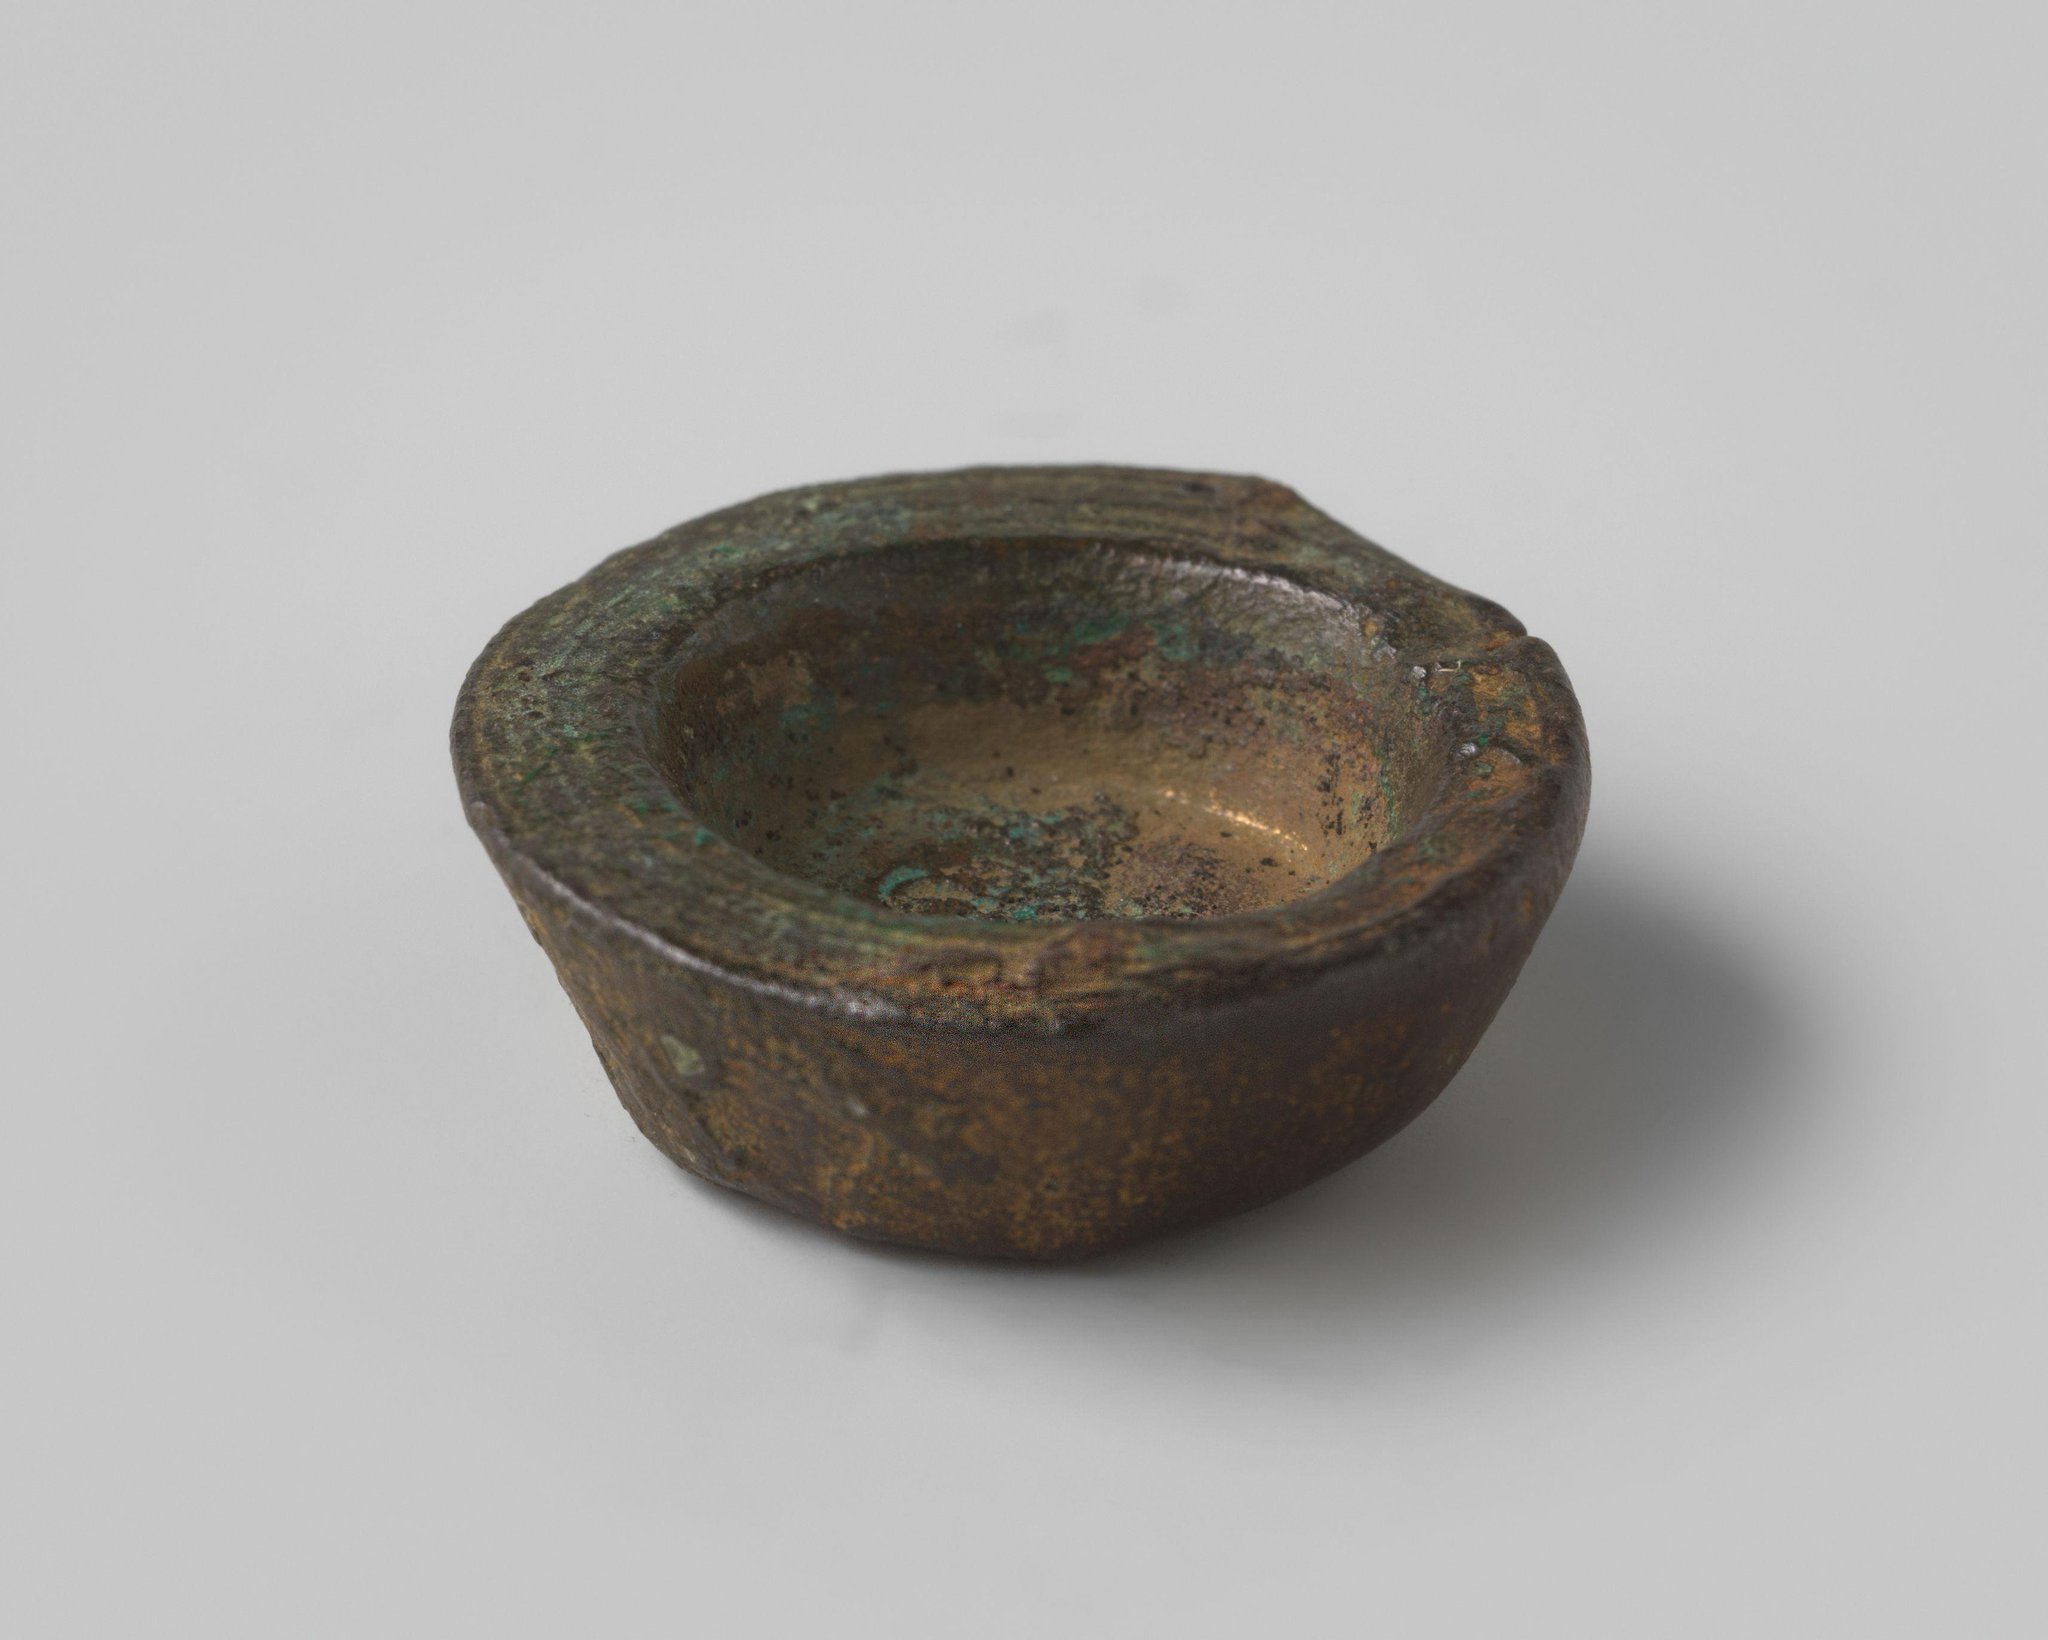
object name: sluitgewicht, pijlgewicht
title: Gewicht van sluitgewicht uit het wrak van de Oost-Indiëvaarder Hollandia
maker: Anonymous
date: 1700-1743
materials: copper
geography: netherlands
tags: verenigde oostindische compagnie, hollandia (schip), annet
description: Weight, cupweight, cup; id. NG 1980-27H2775, corroded, id. mark partly legible.